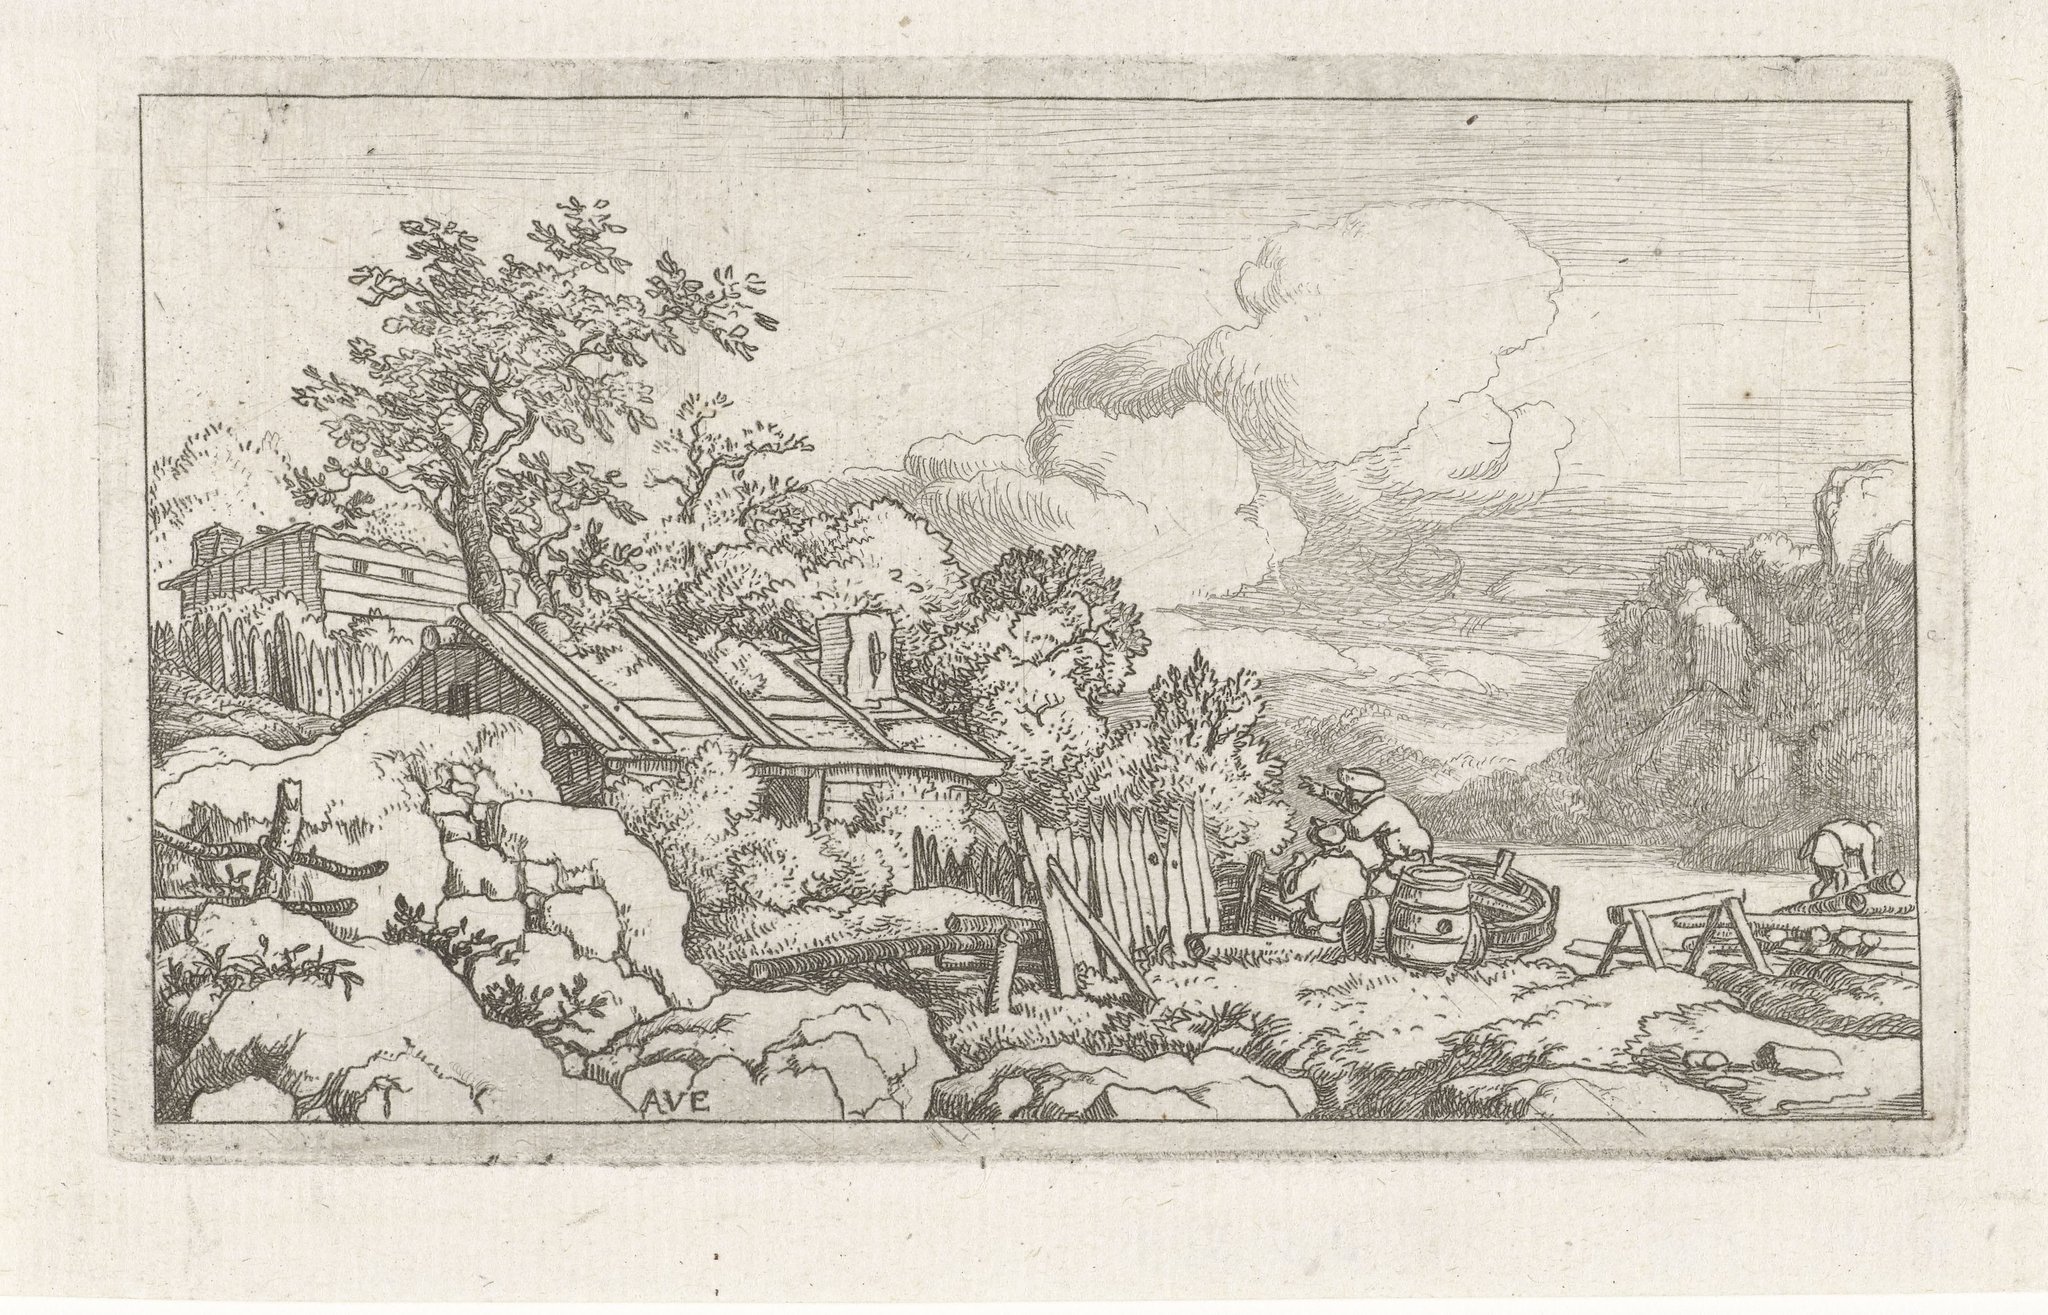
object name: print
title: De hut van de timmerman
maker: allaert van everdingen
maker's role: draughtsman, painter, print maker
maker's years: 1621-1675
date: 1651-1675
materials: paper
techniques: etching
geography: netherlands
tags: timber yard, lumber stack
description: Landschap met vervallen hut tussen bomen en struikgewas. Aan de waterkant zit een persoon op een boomstam naast een wijzende man. Op de achtergrond een schraag en een derde persoon gebukt bij boomstammen.